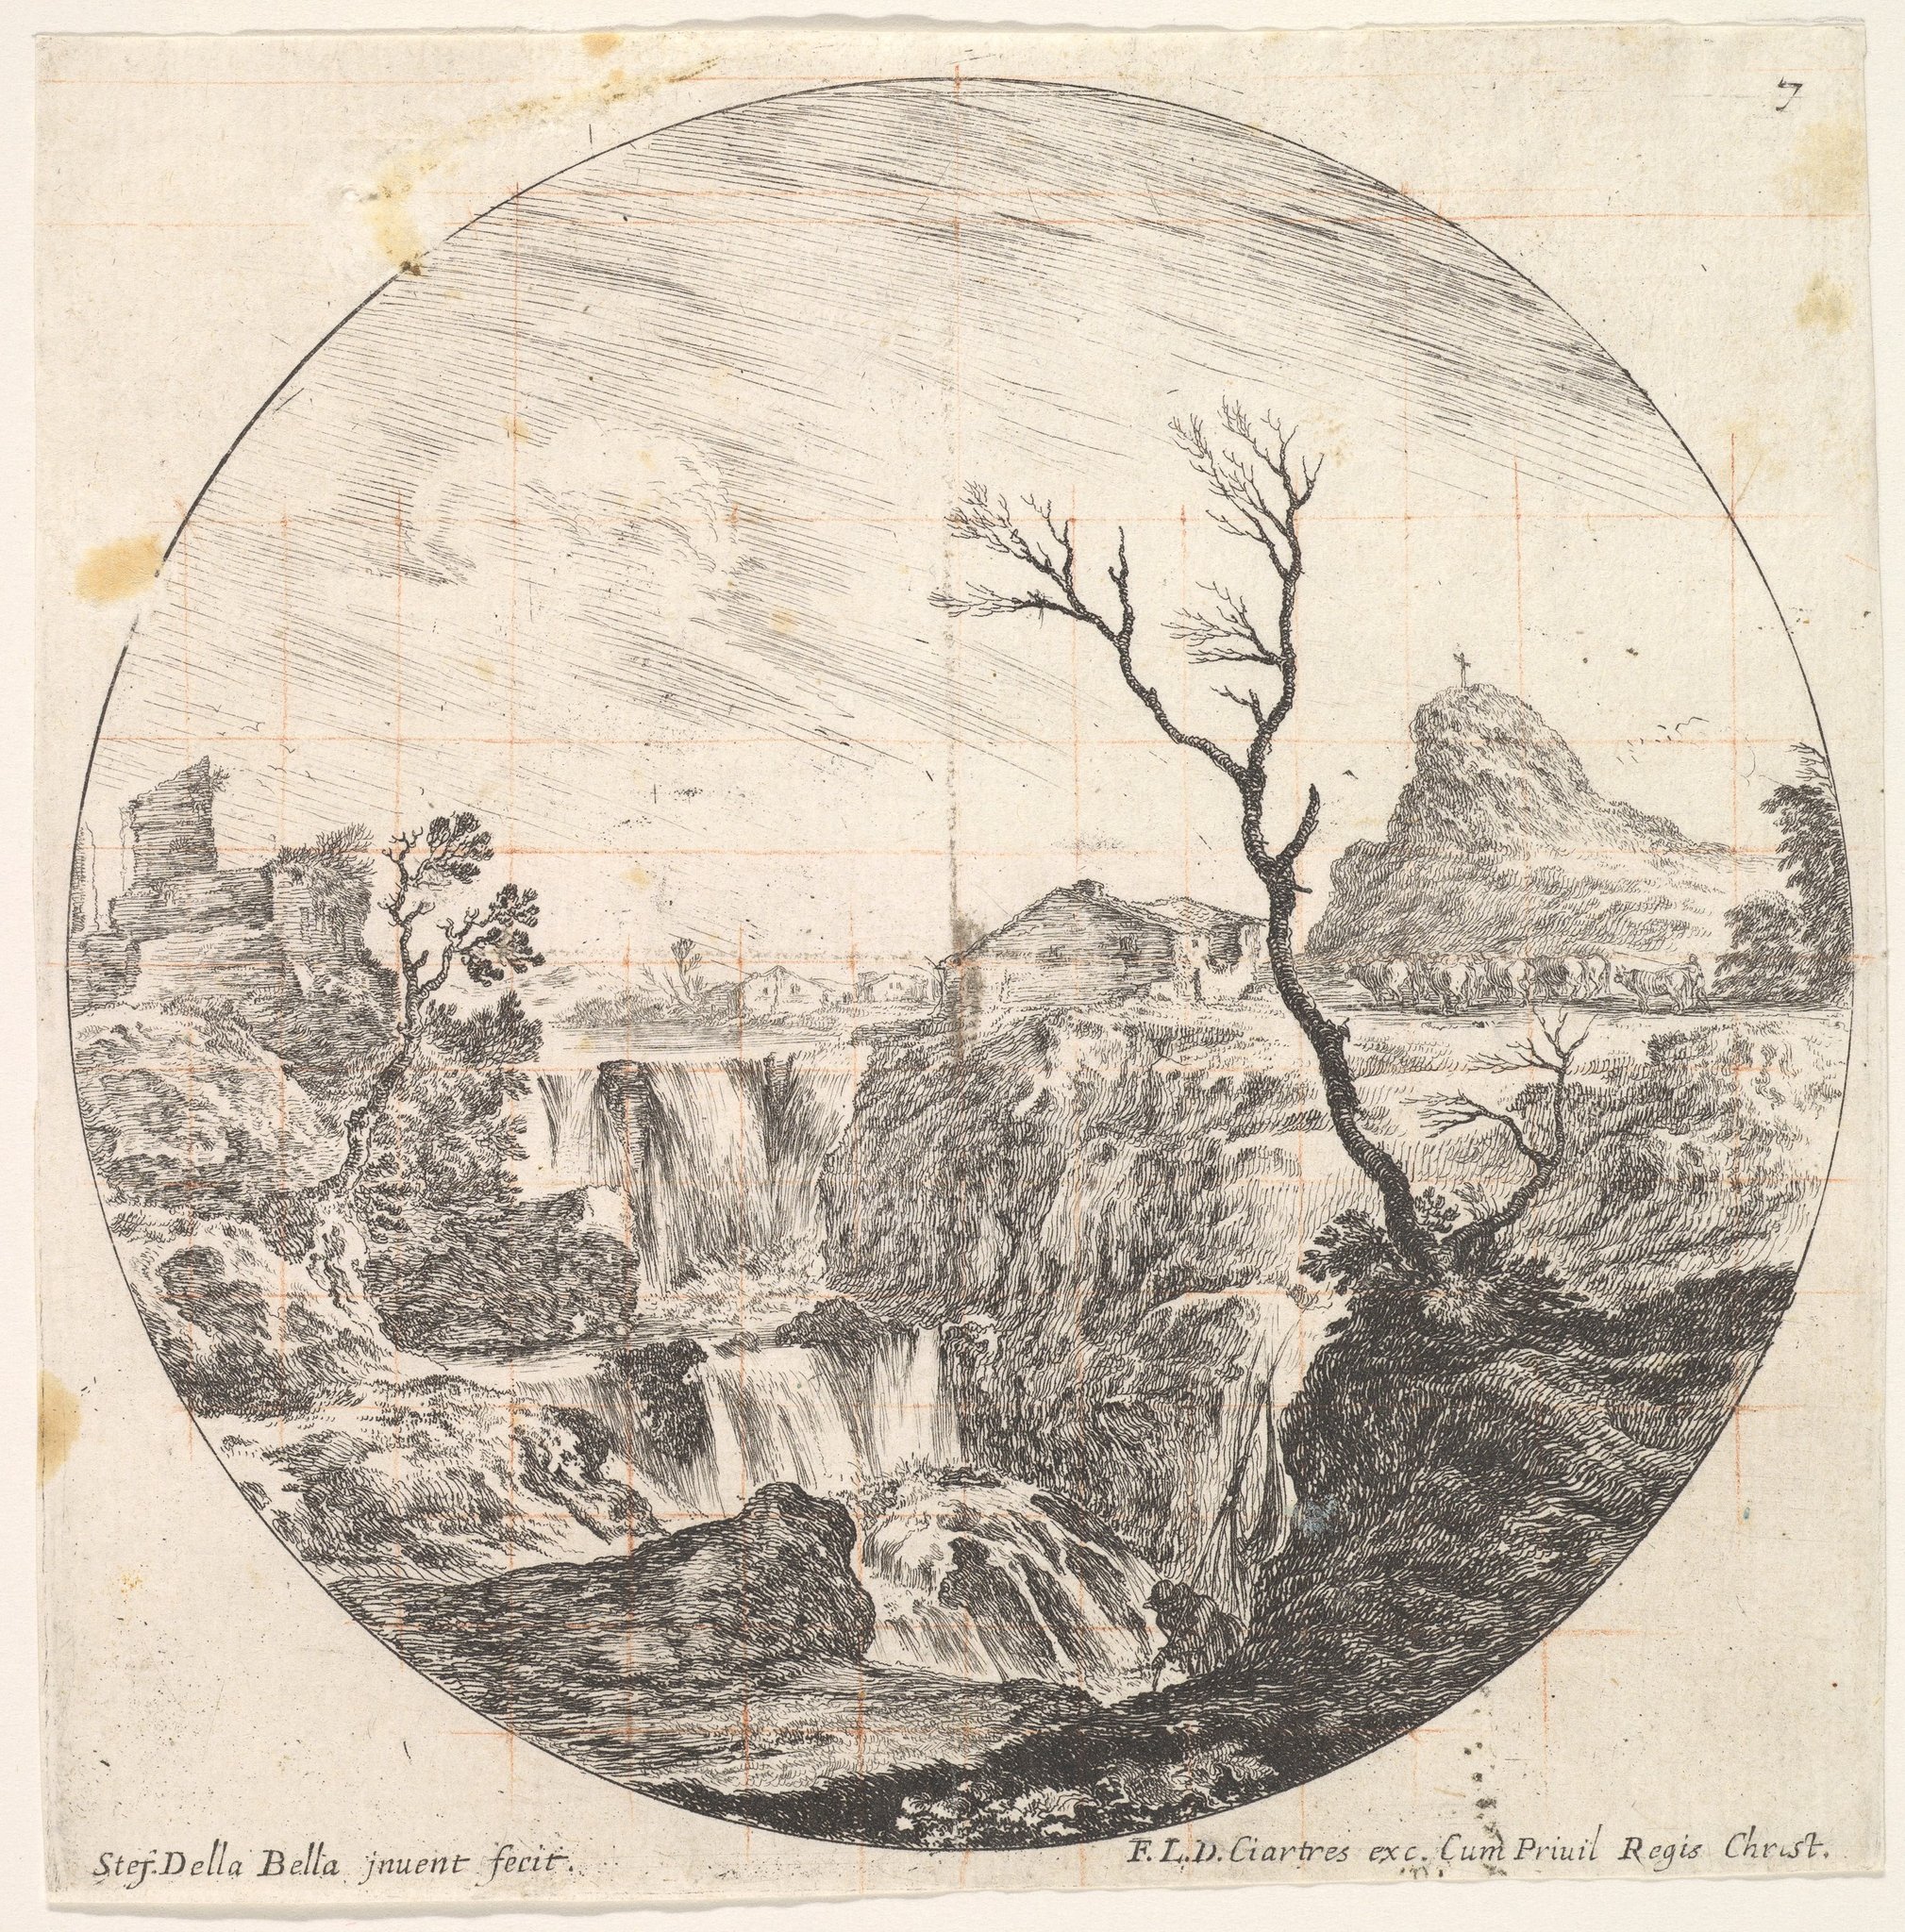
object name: print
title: Plate 7: a triple waterfall, a dead tree to right, a mountain and a herd of cows to right in the background, from "Roman landscapes and ruins" (Paysages et ruines de Rome)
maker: stefano della bella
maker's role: artist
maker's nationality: italian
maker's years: 1610-1664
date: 1643-1648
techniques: etching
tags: cows,waterfalls,landscapes,trees